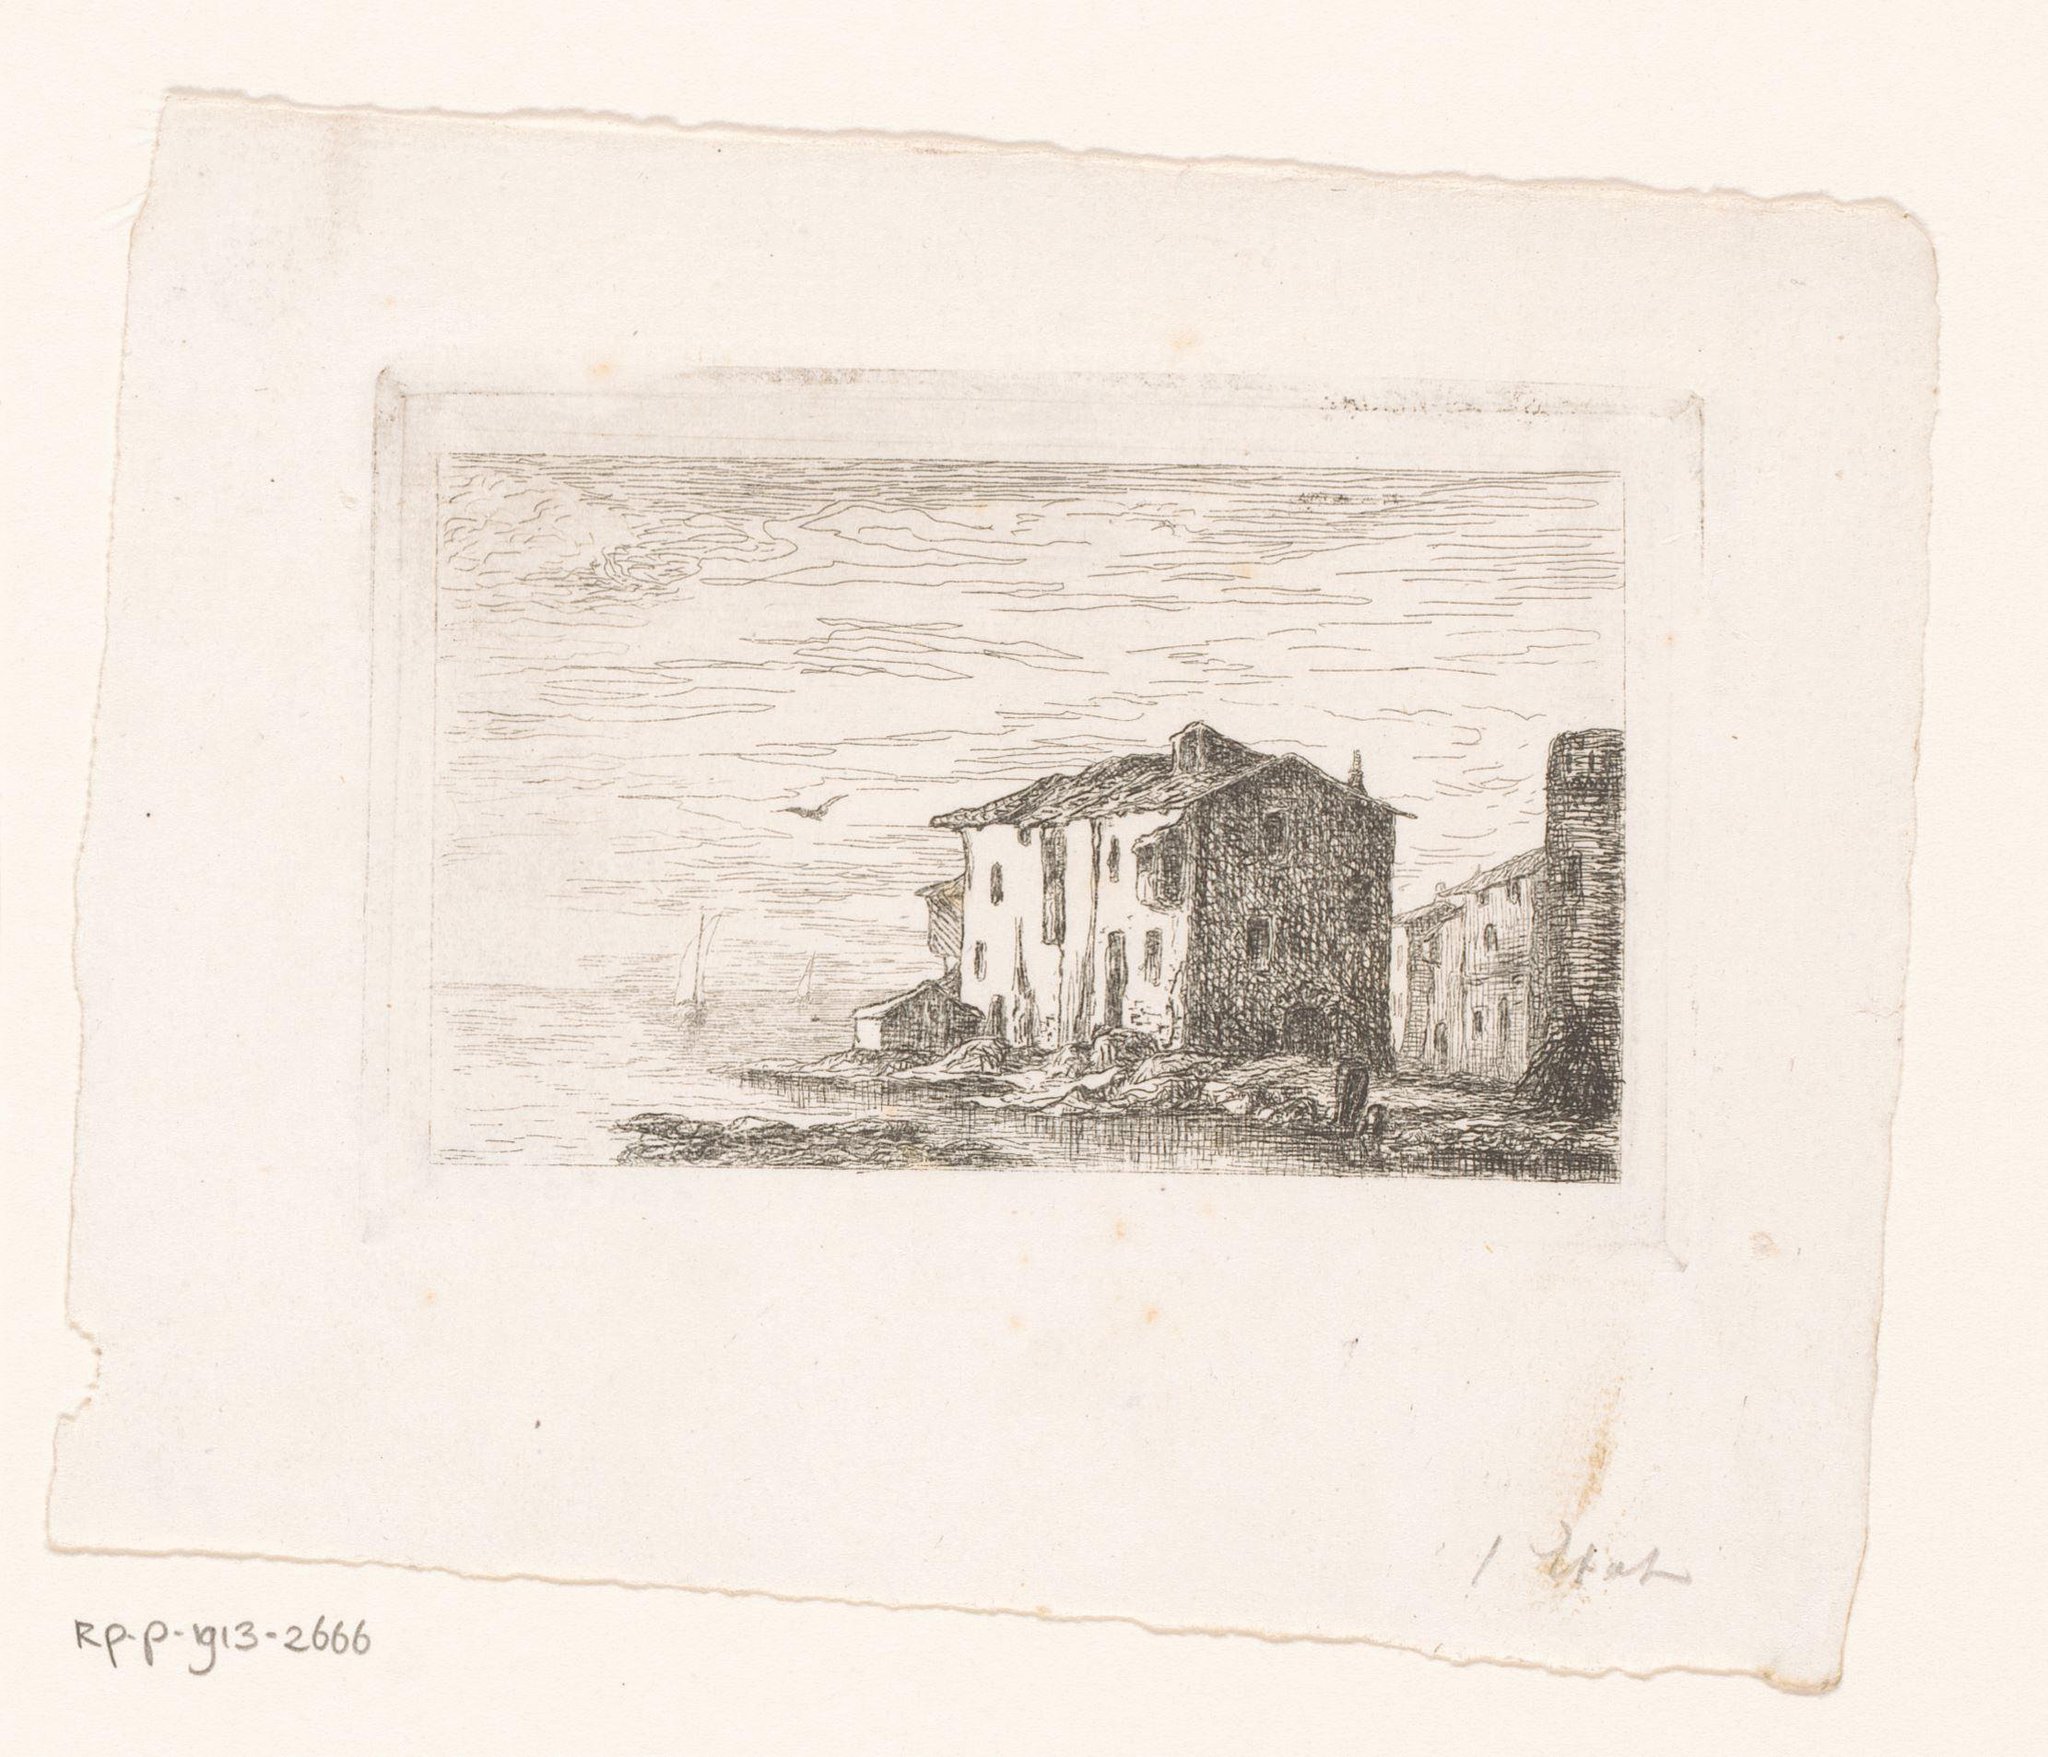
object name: print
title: Huizen langs de kust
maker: emilie rolin-jacquemijns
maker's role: print maker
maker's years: 1842-1906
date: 1852-1906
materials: paper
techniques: etching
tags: housing, coast, sea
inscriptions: collector's mark: Lugt 2228